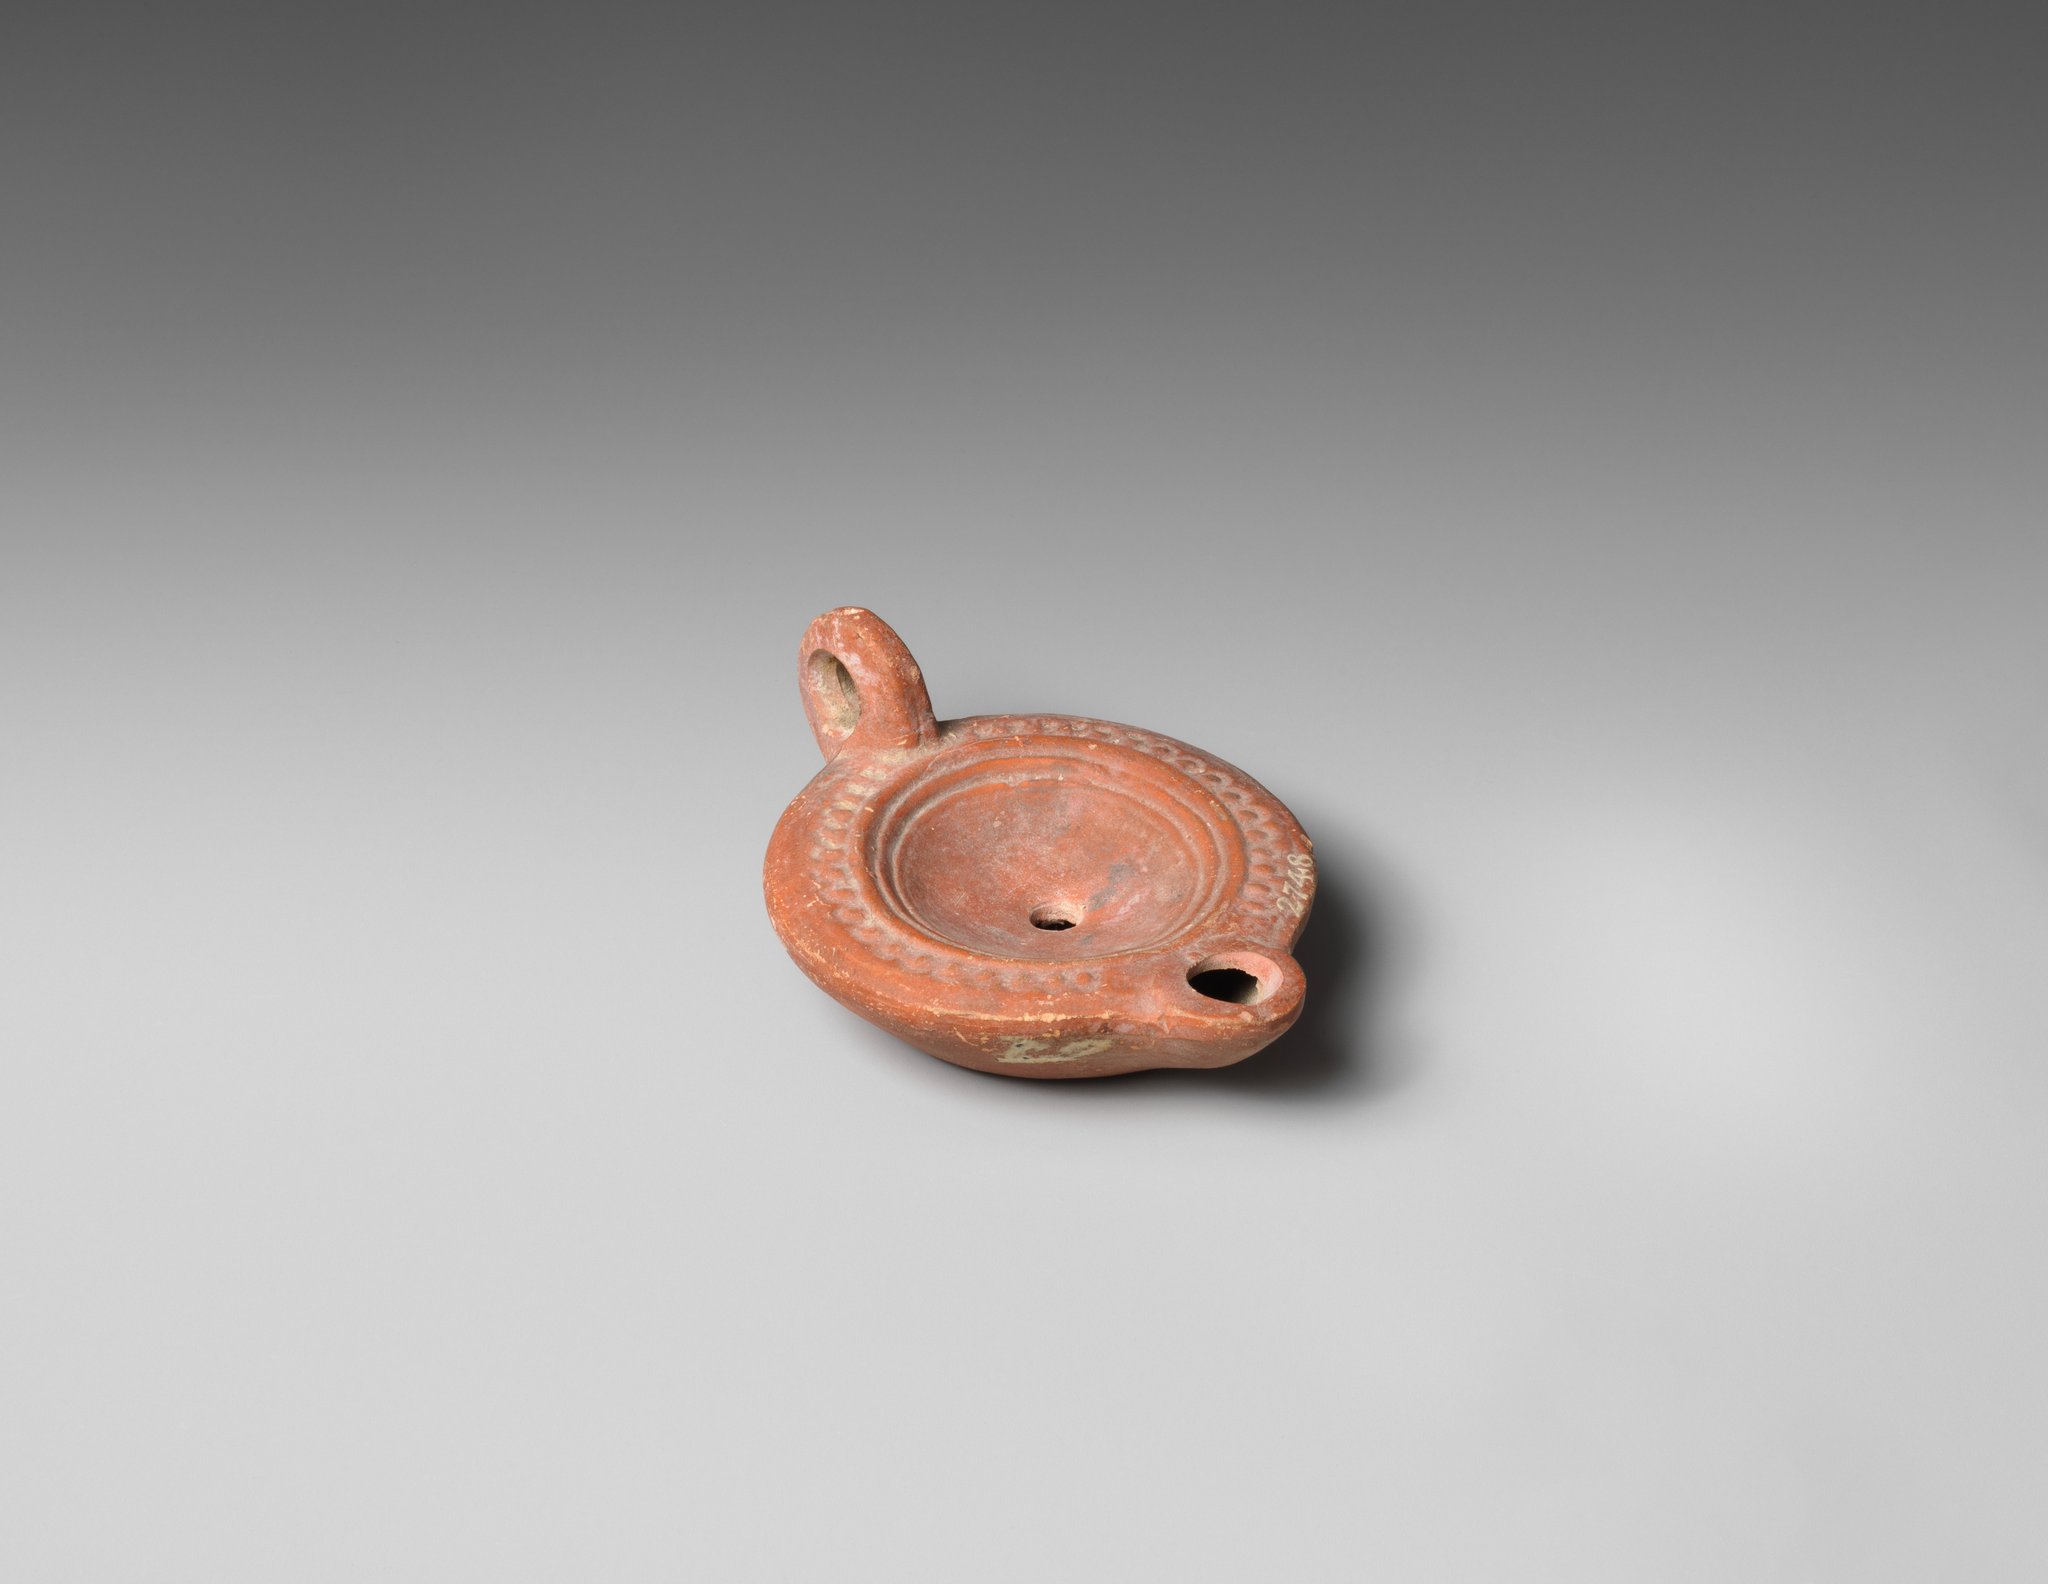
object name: lamp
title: Terracotta oil lamp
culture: roman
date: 101-200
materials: terracotta